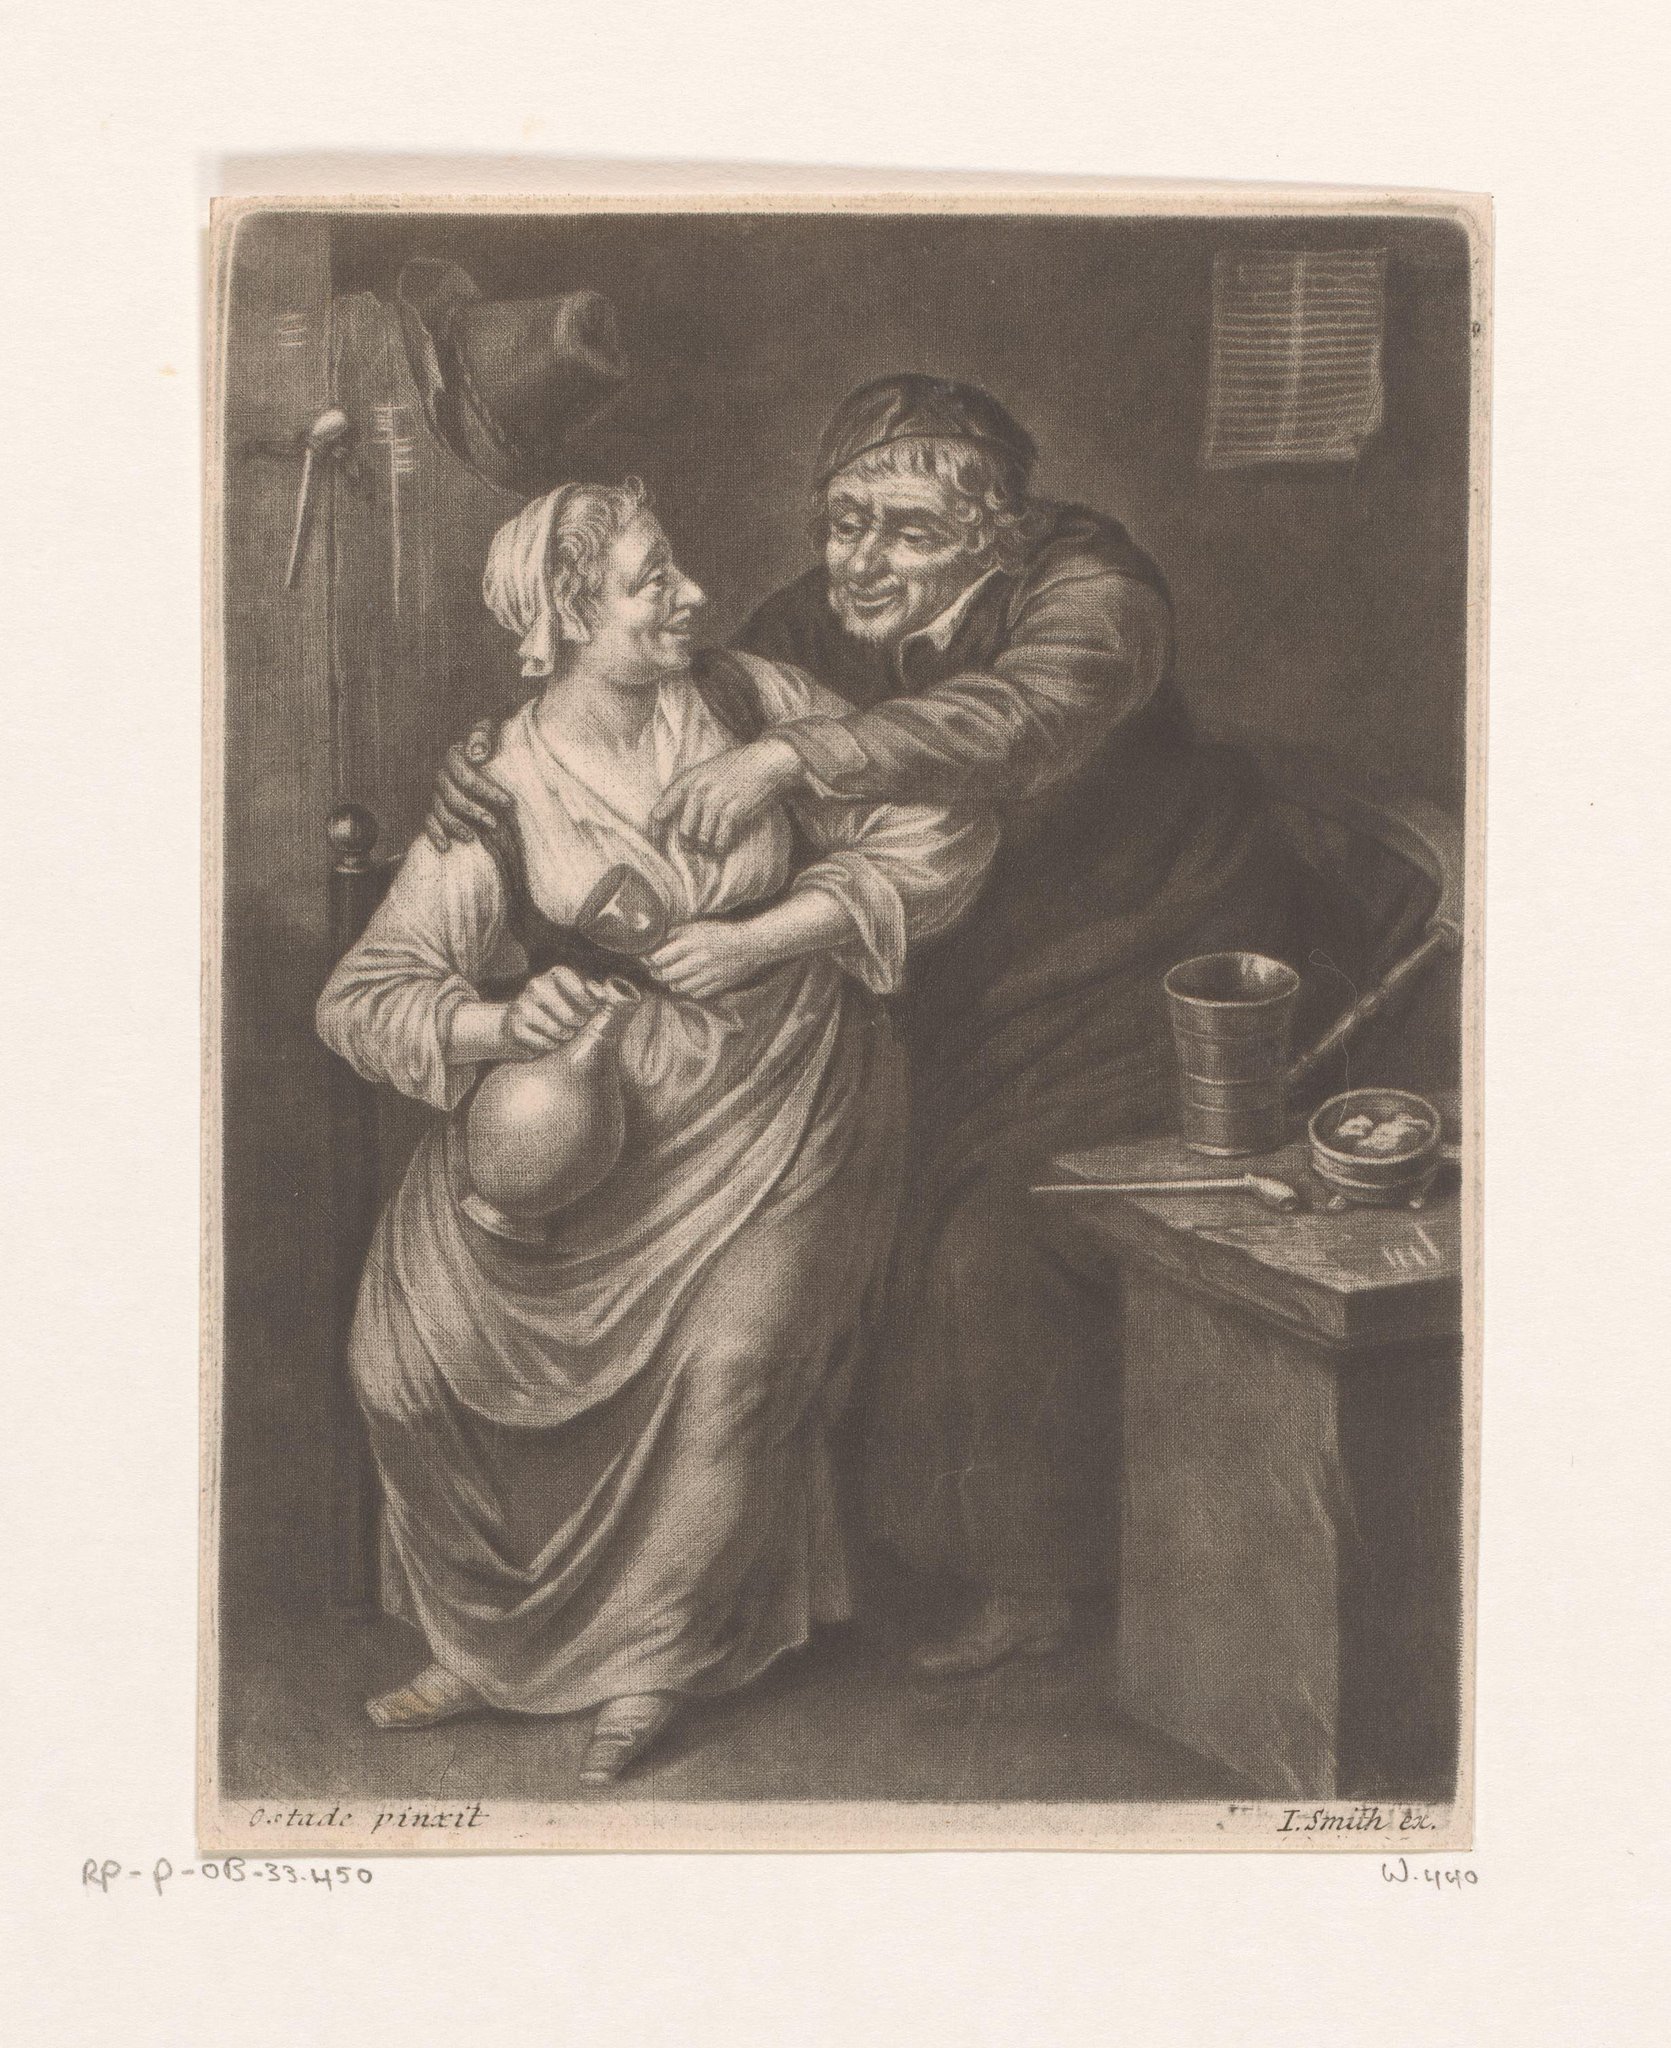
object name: print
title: Herberginterieur met drinkende man en vrouw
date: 1680-1695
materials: paper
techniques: mezzotint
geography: london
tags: drunkenness, alcoholic drinks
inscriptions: collector's mark: Lugt 240